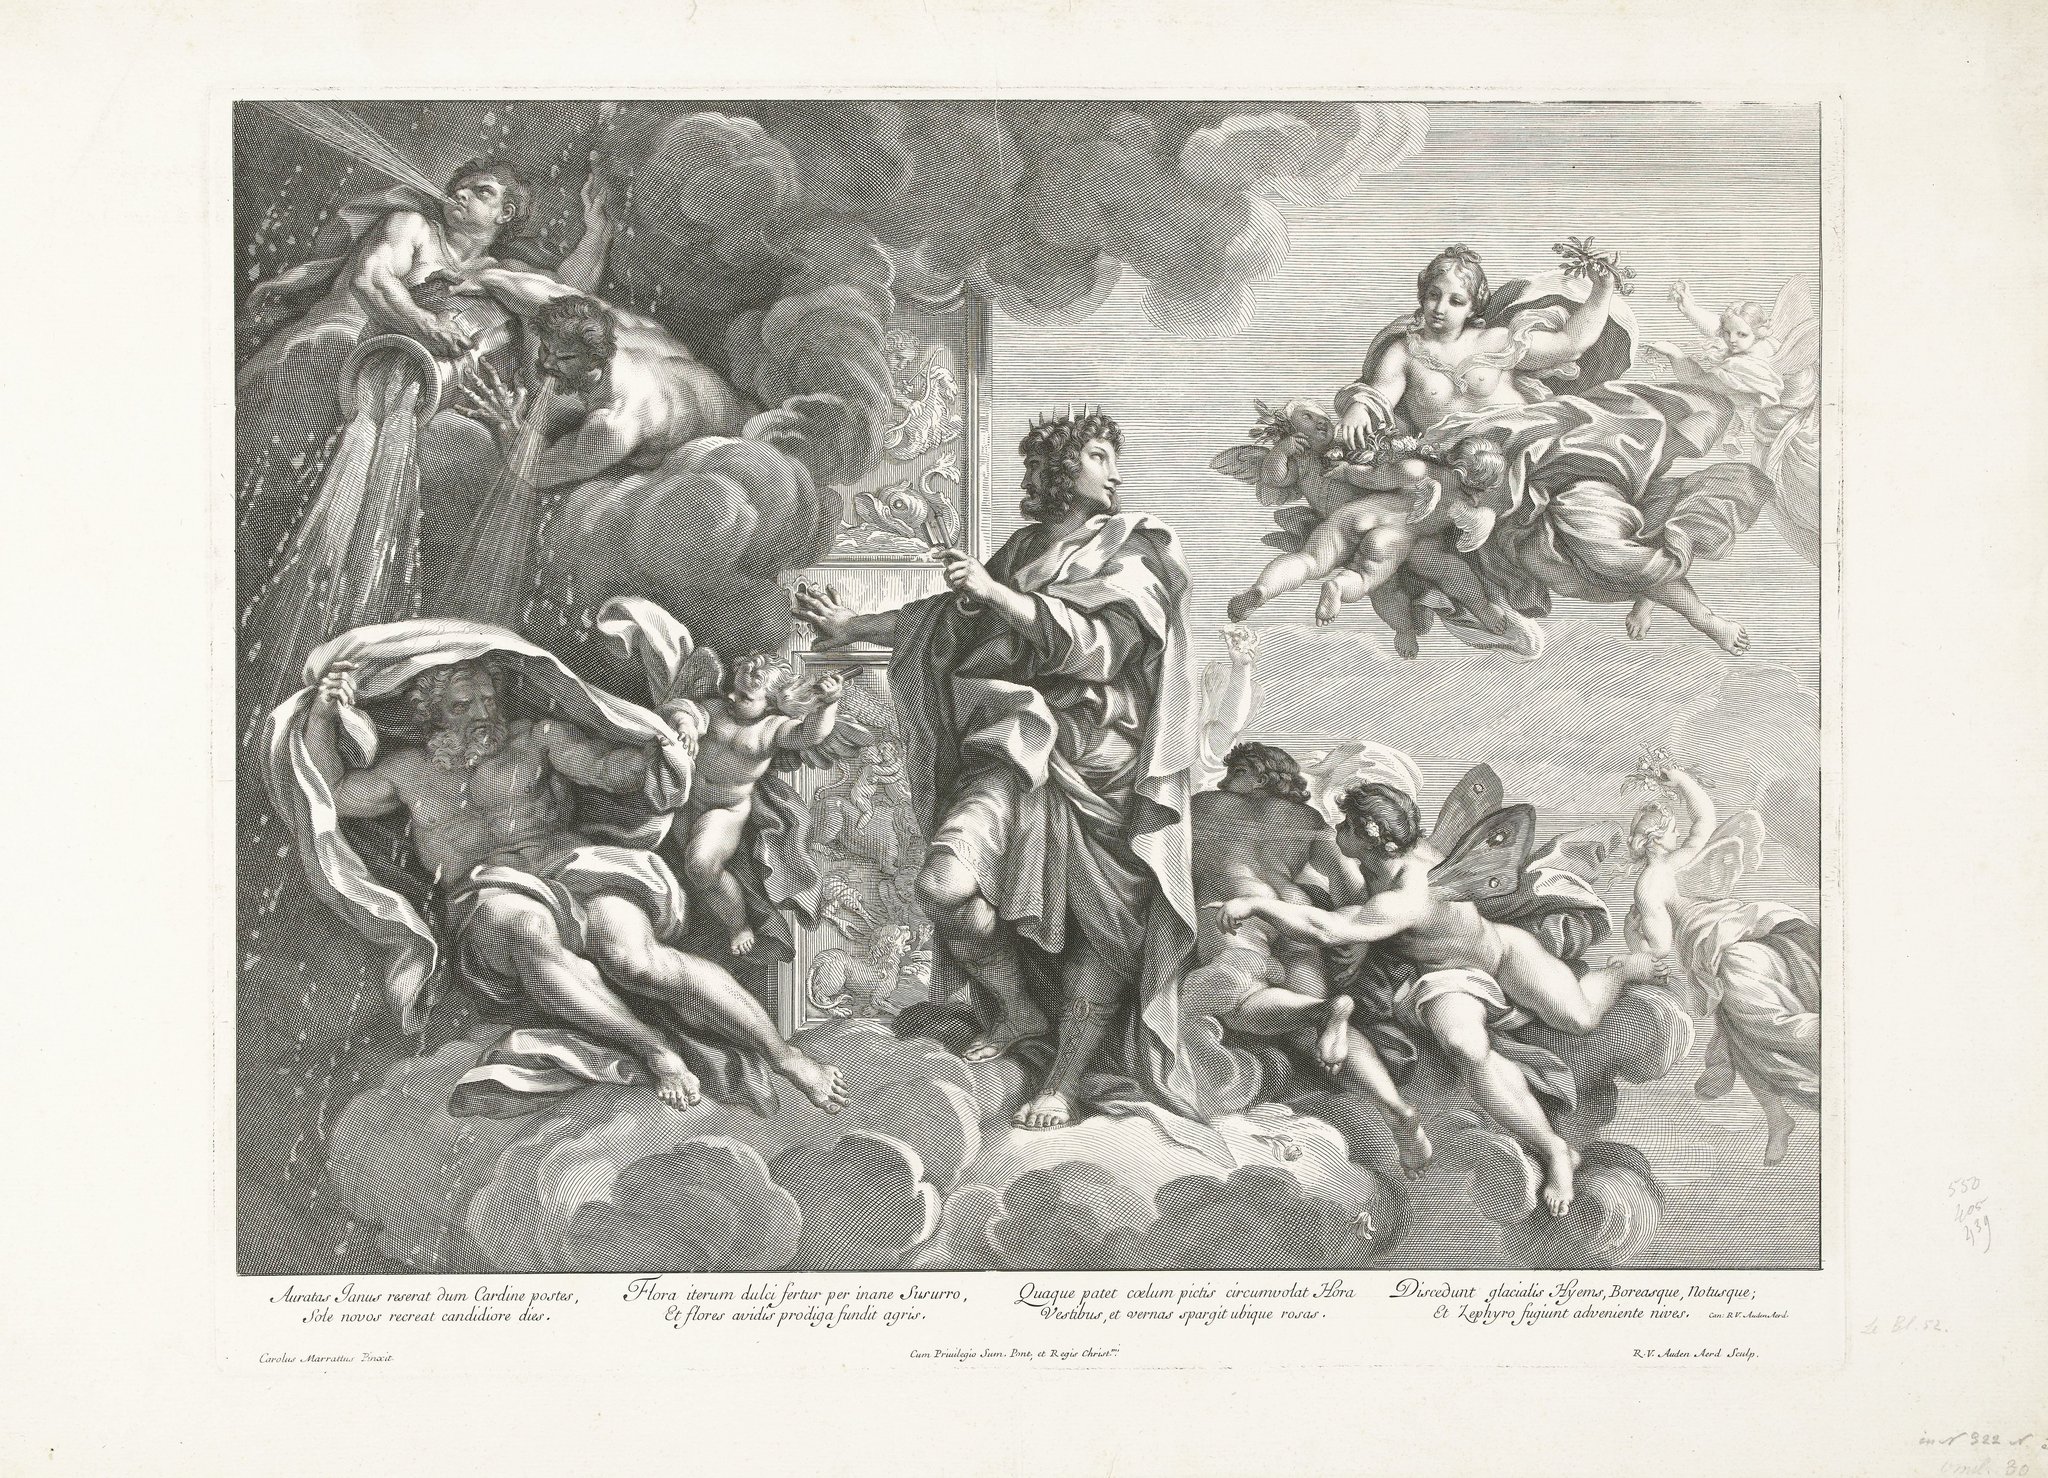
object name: print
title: Janus opent de deur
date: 1685-1723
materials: paper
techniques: engraving, etching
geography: rome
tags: 'pioggia, ninfa dell'aria' (ripa), spring, 'ver'; 'primavera' (ripa), janus' head, two-faced head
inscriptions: collector's mark: Lugt 240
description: De god Janus opent met een sleutel de jaarpoort. Janus verjaagd regen en storm, in de vorm van twee mannen die water op de aarde spugen en gieten, en een oude man die met een groot doek de wind maakt. De weg is nu vrij voor de Lente met haar gevolg van putti met bloemen. Onder de voorstelling een Latijns vers door Robert van Audenaerd zelf geschreven.